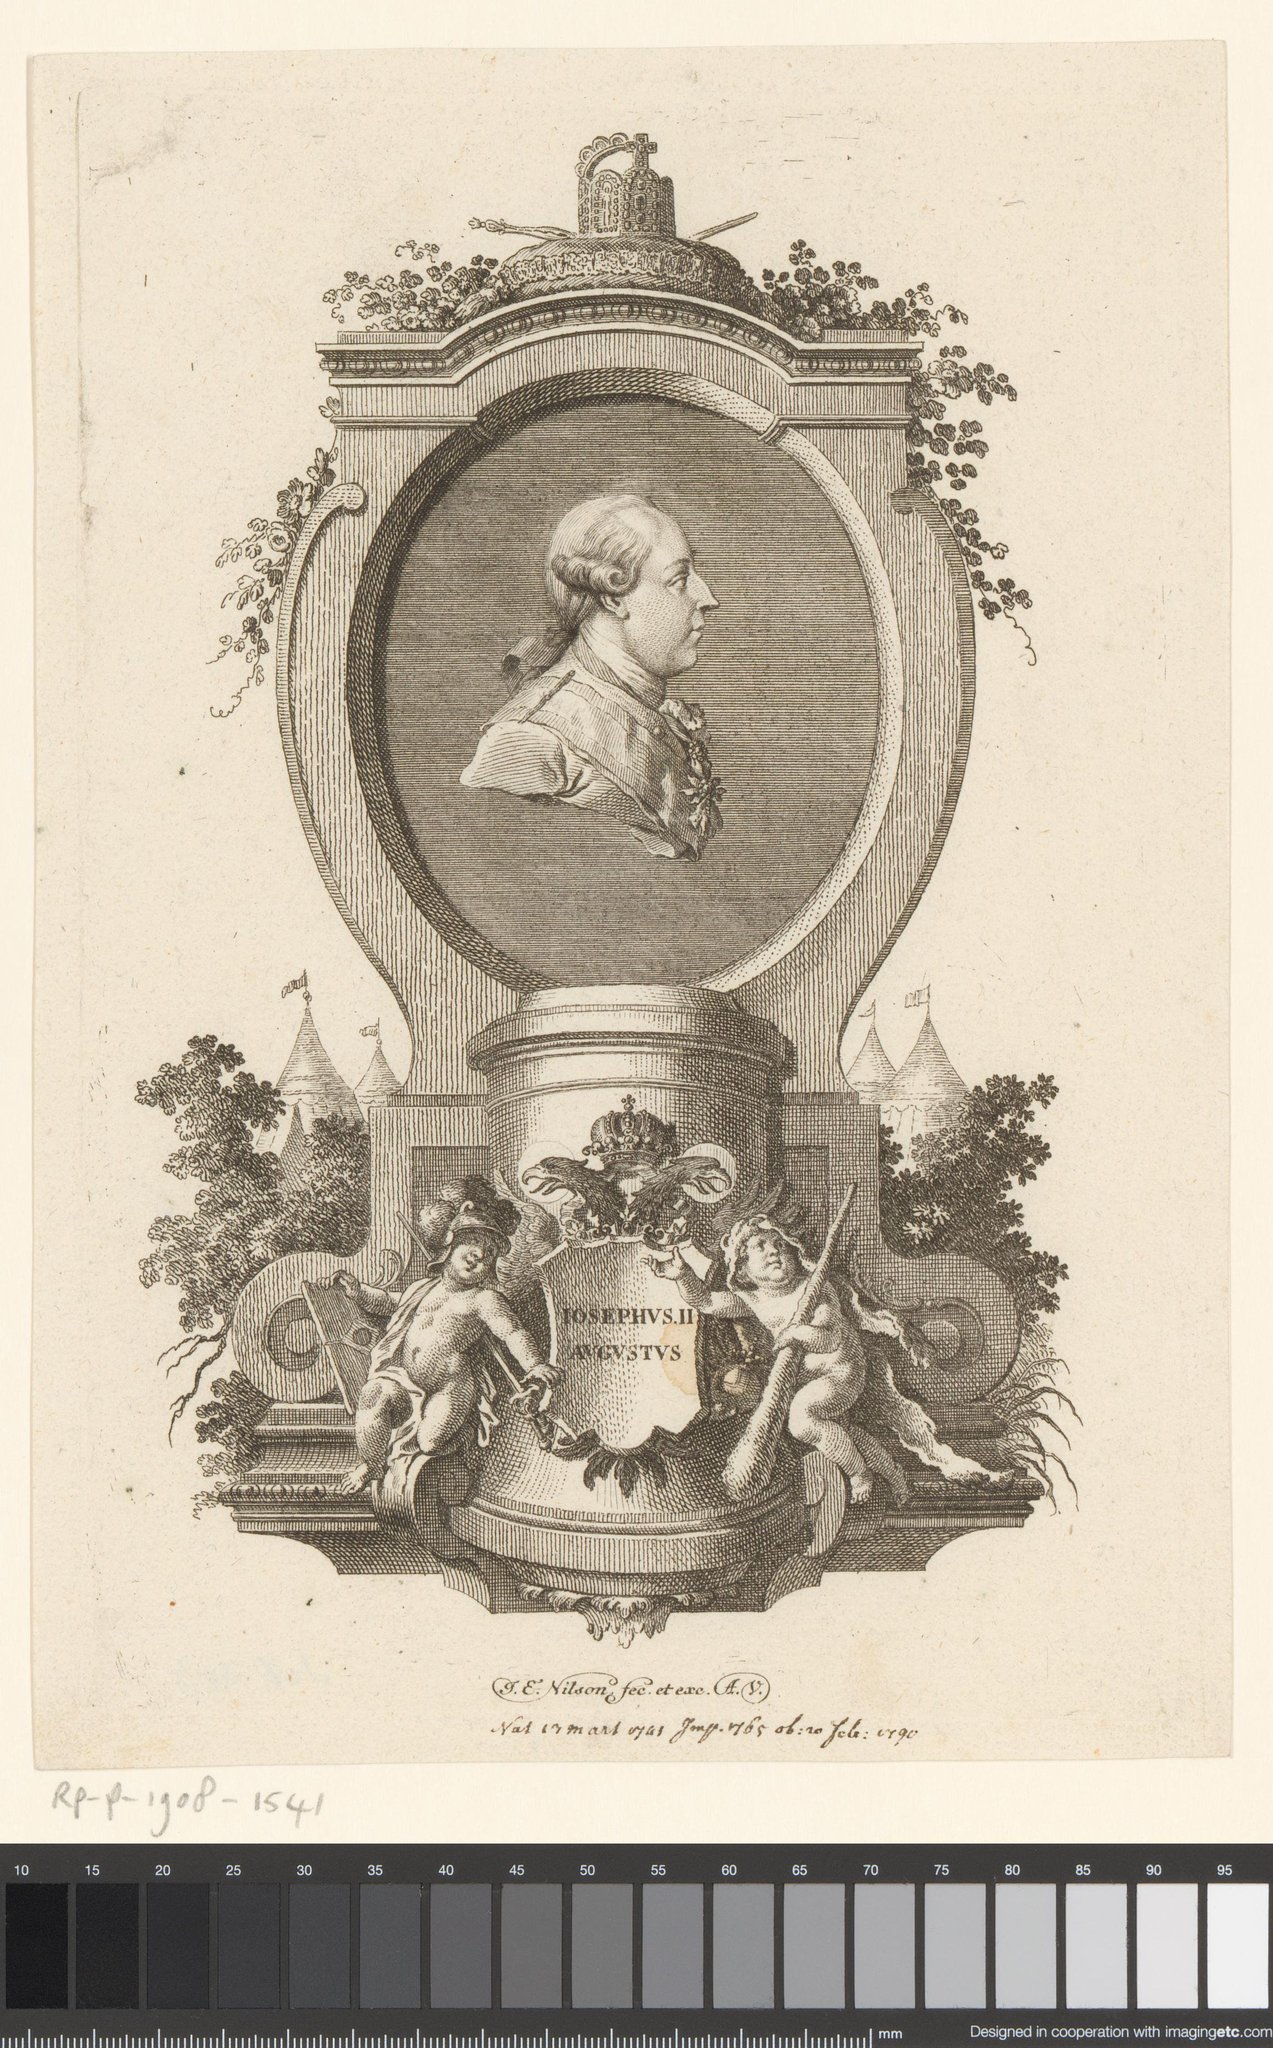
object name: print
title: Portret van Jozef II, Rooms-Duits keizer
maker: johann esaias nilson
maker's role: draughtsman, print maker, publisher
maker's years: 1721-1788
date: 1765-1788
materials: paper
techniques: engraving, etching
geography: augsburg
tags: vienna, jozef ii (duits keizer), double-headed eagle, (military) camp with tents, attributes of hercules, historical persons, attributes of mars, armorial bearing, heraldry, insignia and symbols of sovereignty (crown, diadem, sceptre, orb, seal, standard, cloak, pectoral)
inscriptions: collector's mark: Lugt 2228